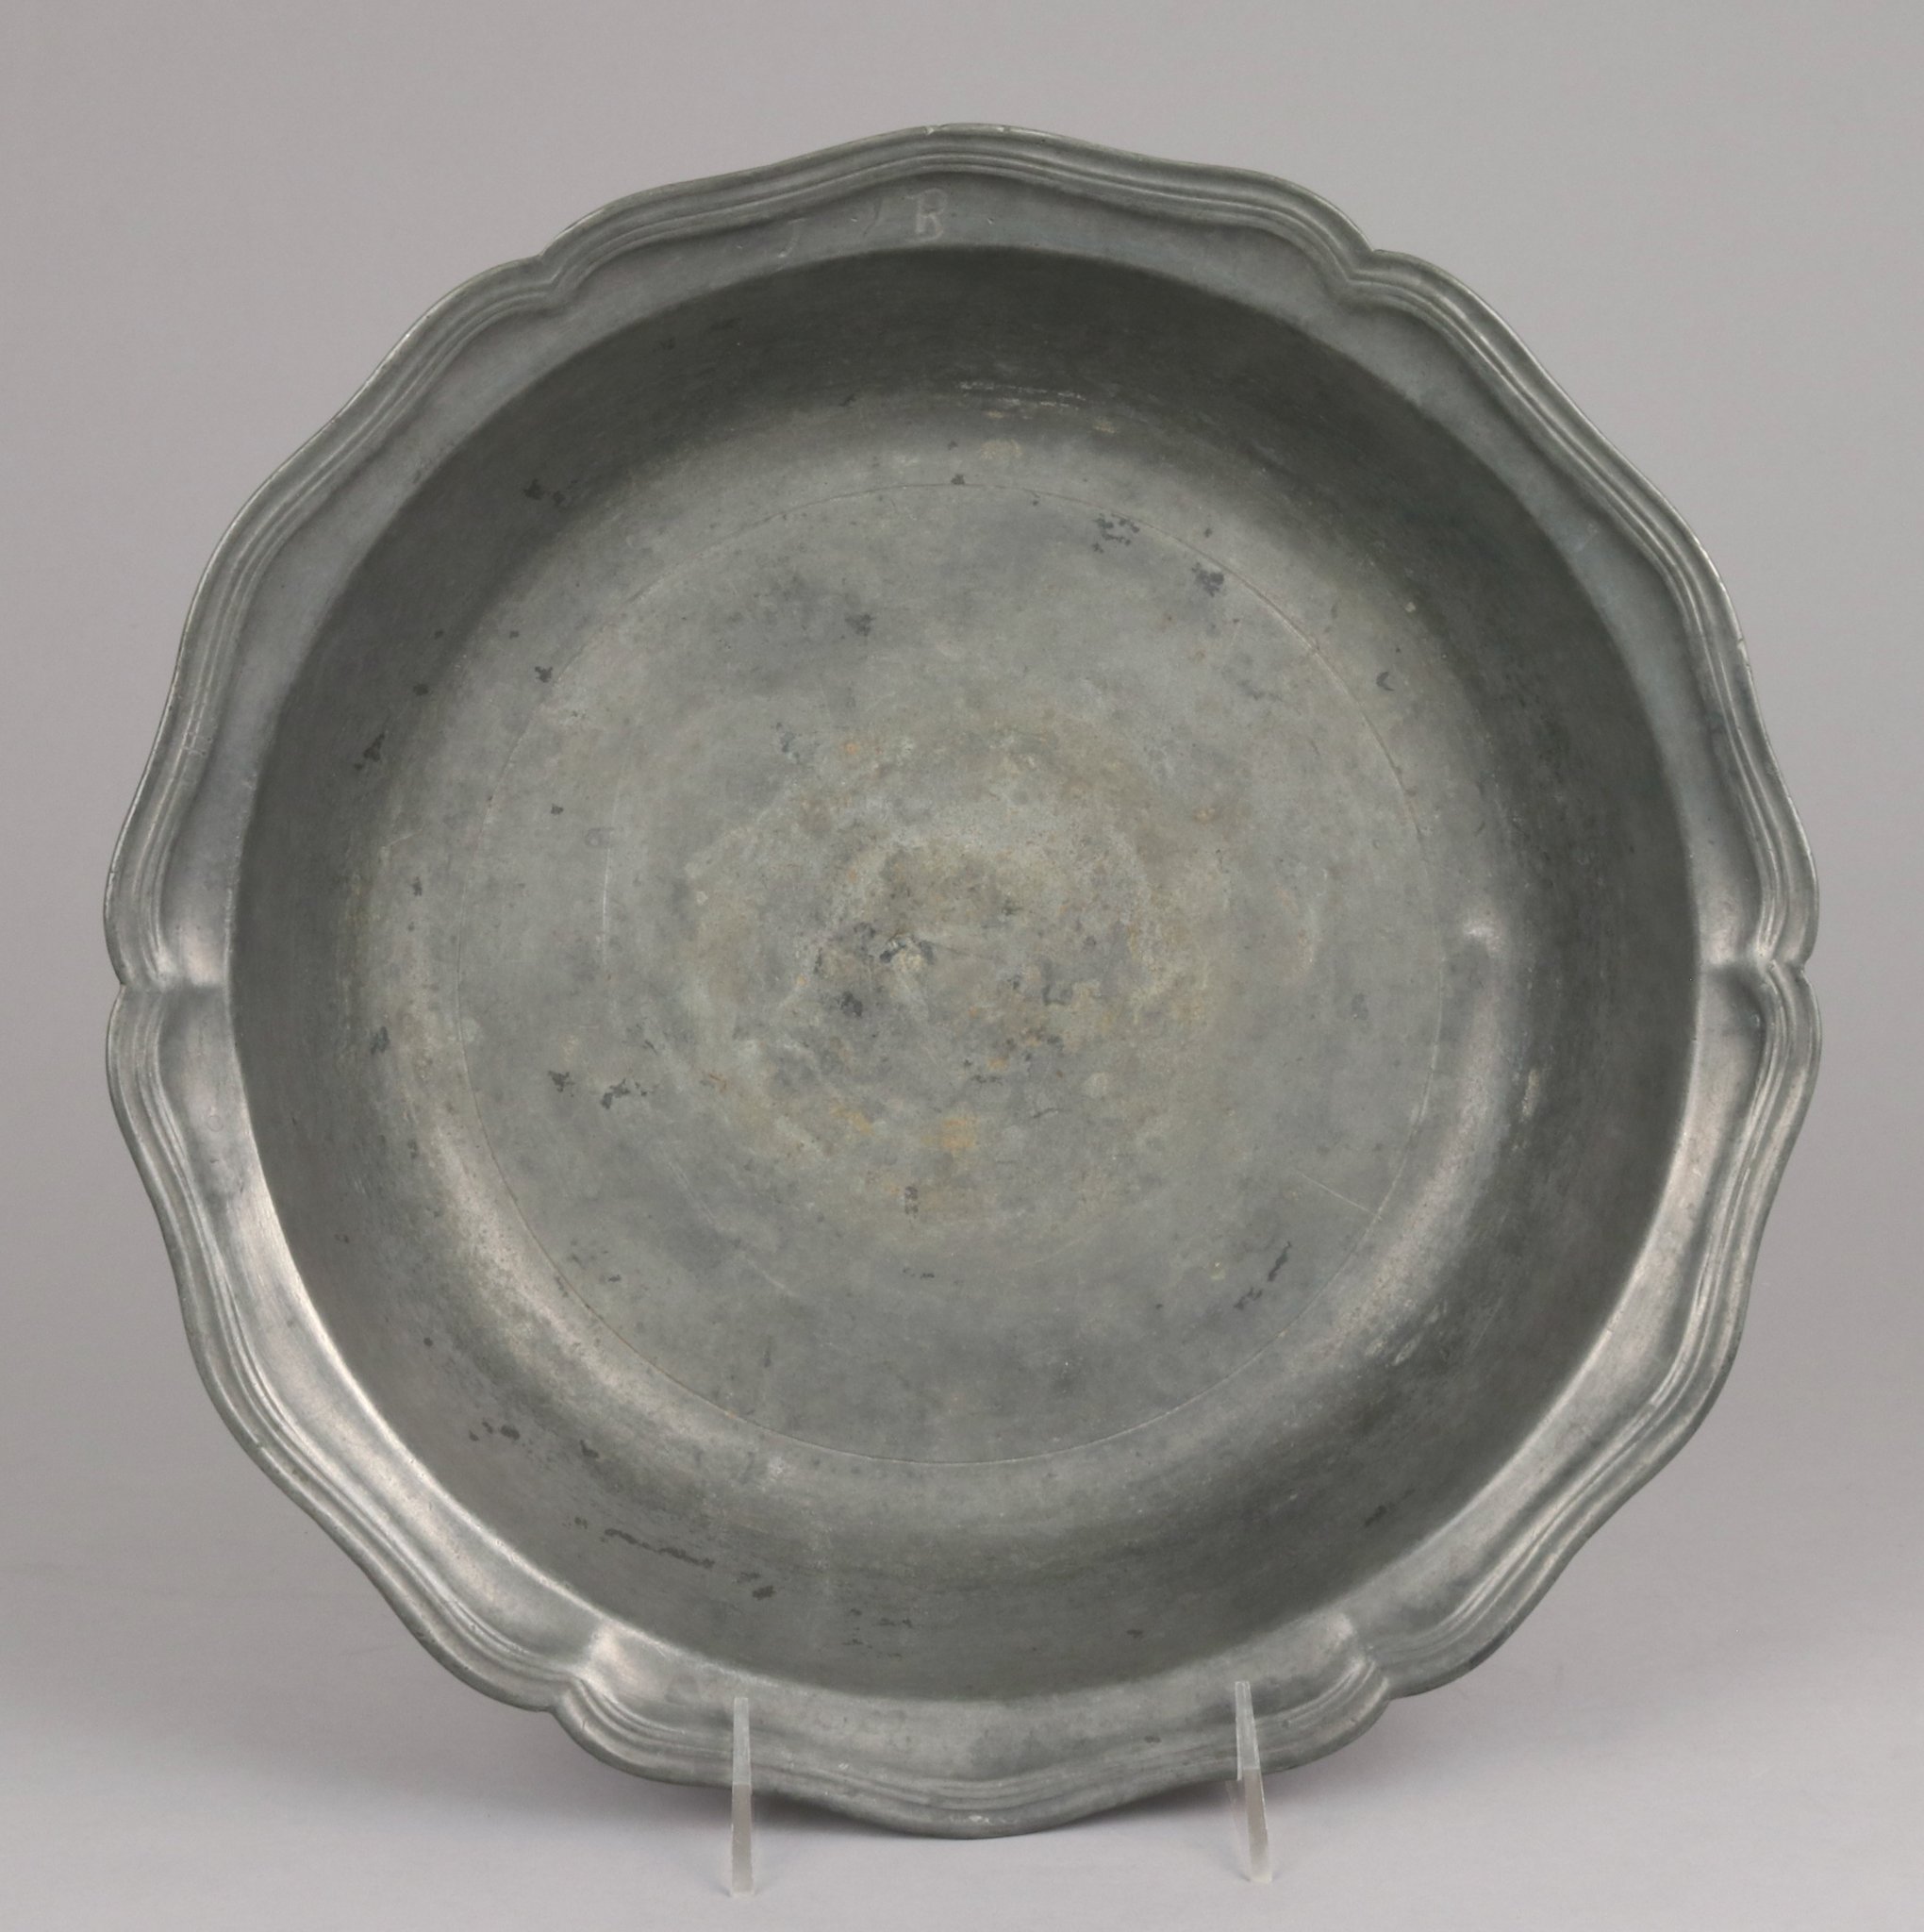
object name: bowl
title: Bowl (one of a pair)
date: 1701-1800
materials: pewter